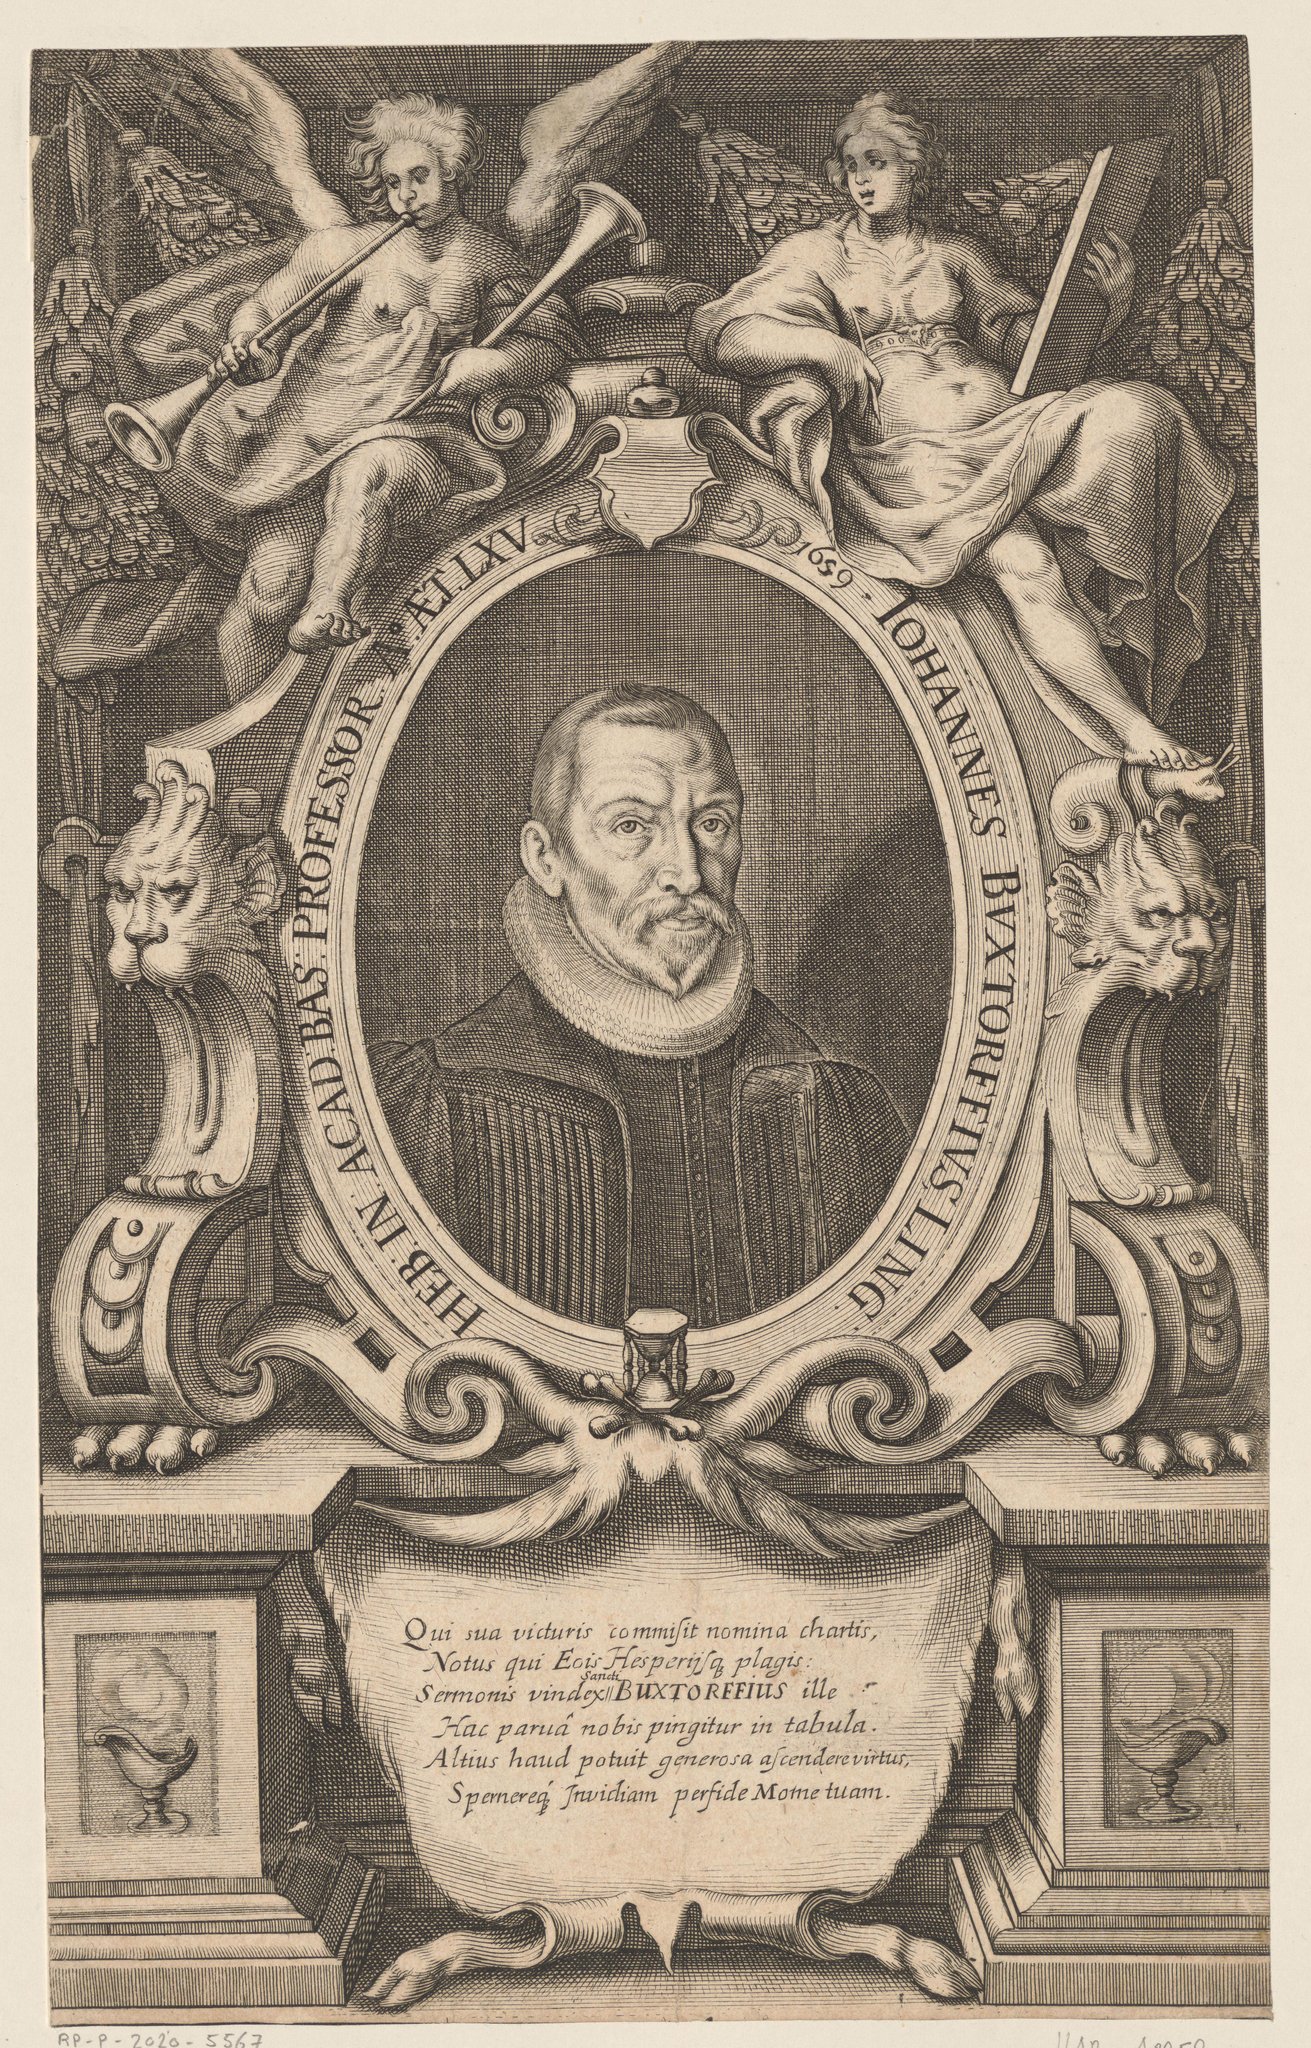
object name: print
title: Portret van Johann Buxtorf (I)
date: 1629-1645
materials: paper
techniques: engraving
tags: westphalia, theologian, historical persons, fame; 'fama', 'fama buona', 'fama chiara' (ripa)